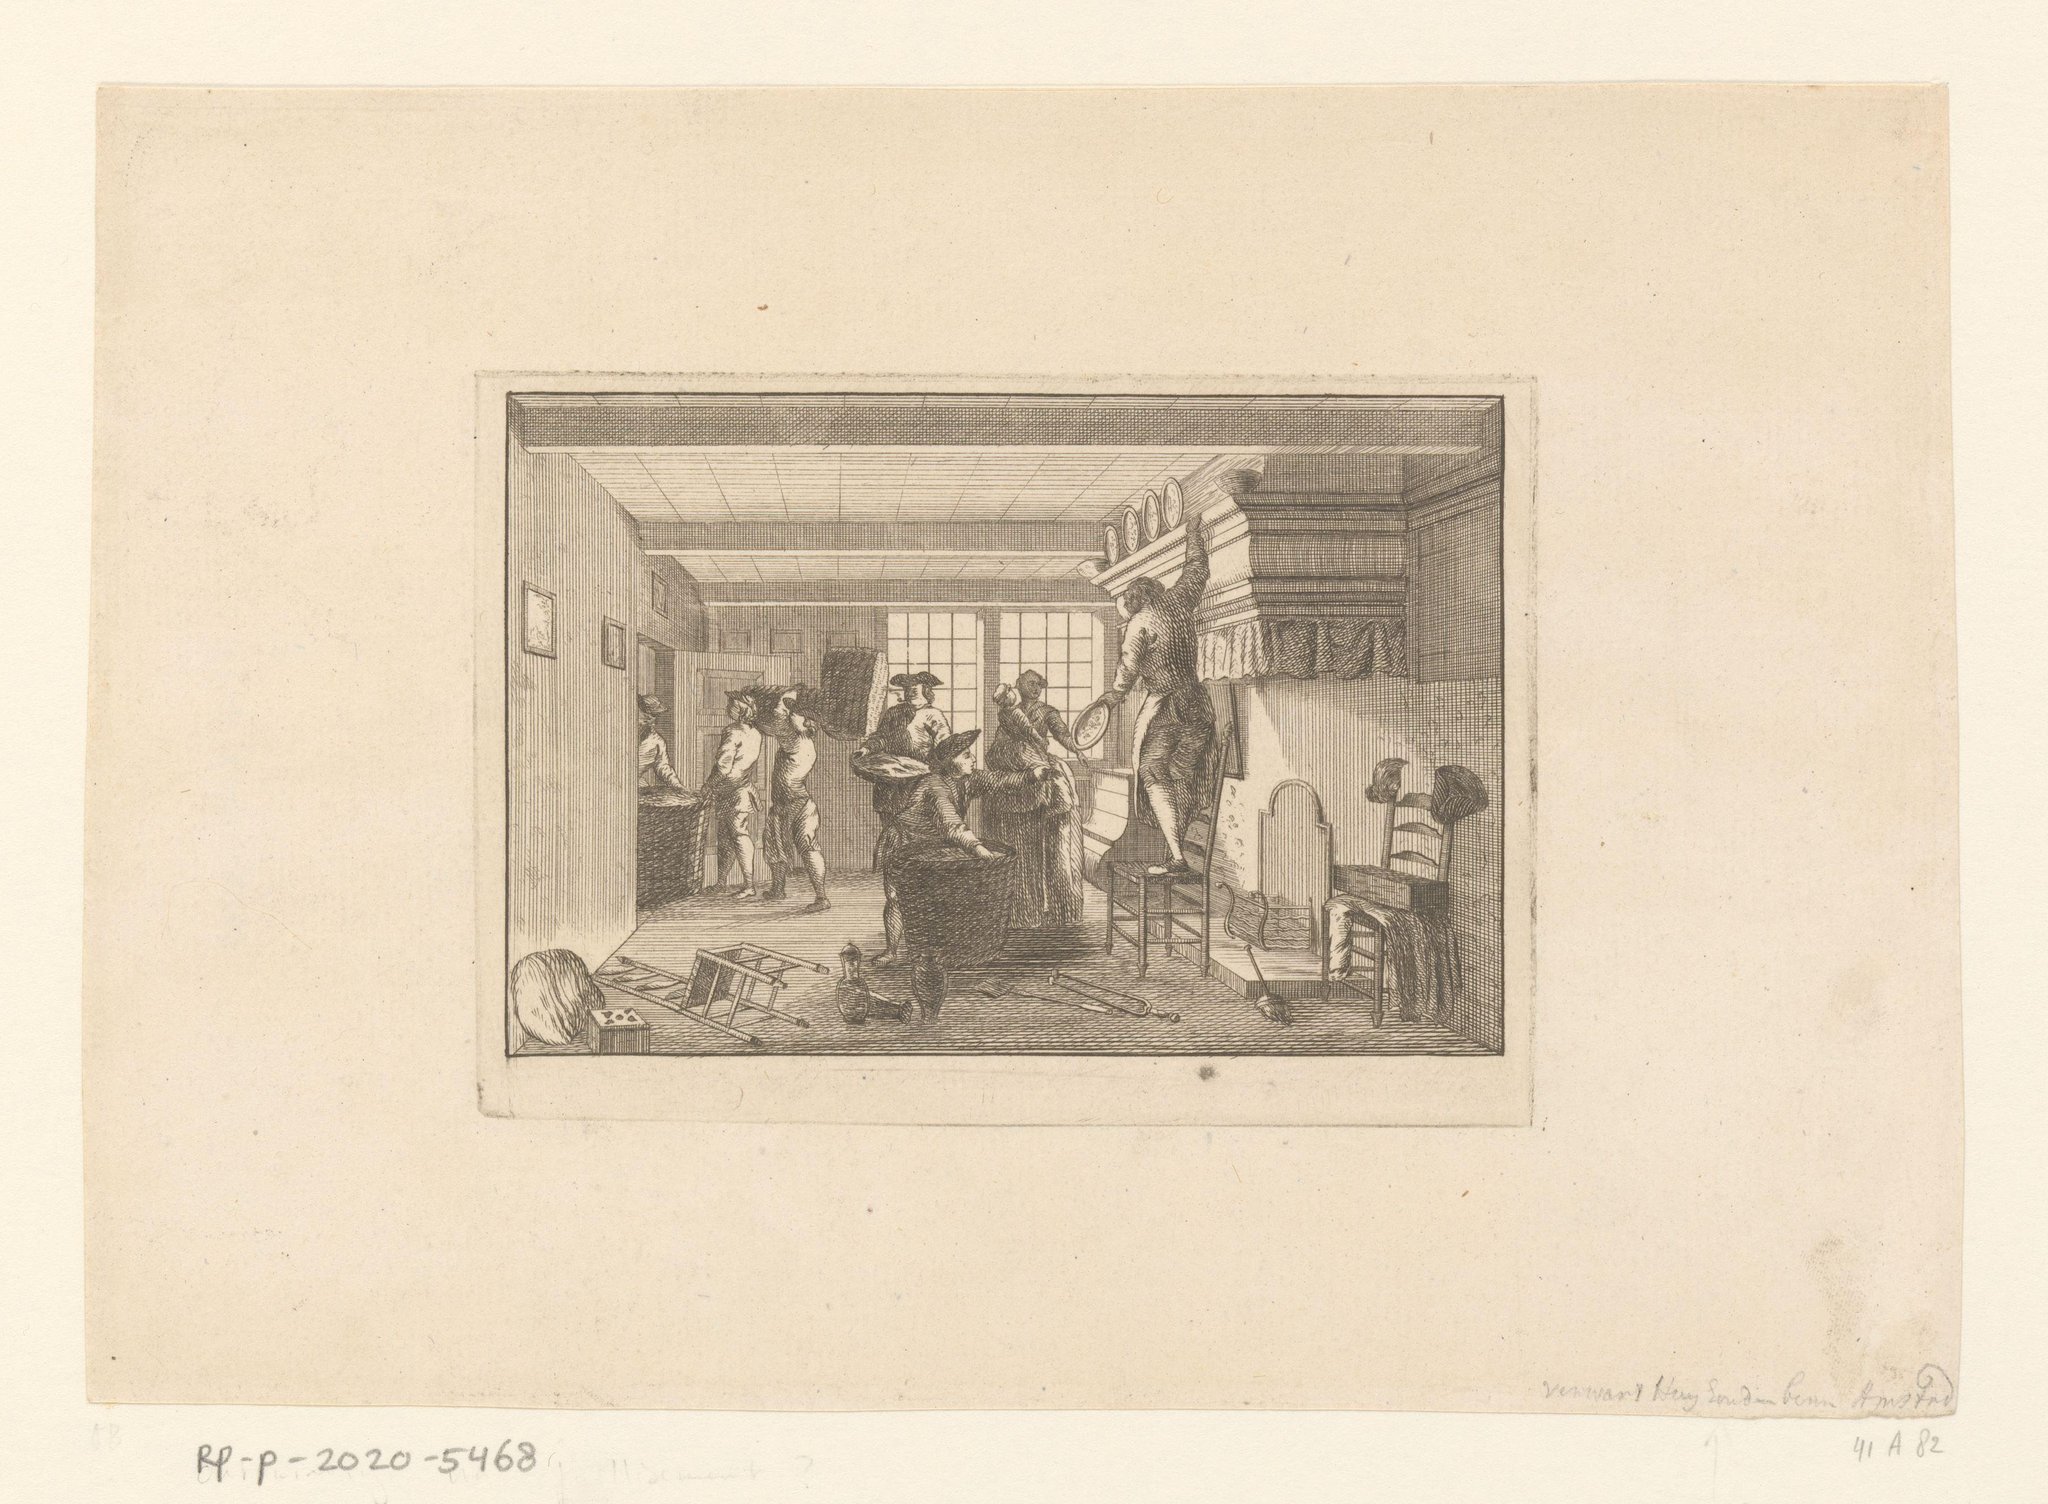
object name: print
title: Figuren halen een kamer met haard leeg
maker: Anonymous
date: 1700-1799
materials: paper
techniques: etching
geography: northern netherlands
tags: moving (house), bankruptcy, hearth and stove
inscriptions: inscription: ‘[...] Amsterd’, collector's mark: Lugt 2228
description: Een kamer wordt leeggehaald, mogelijk vanwege een verhuizing of faillissement.